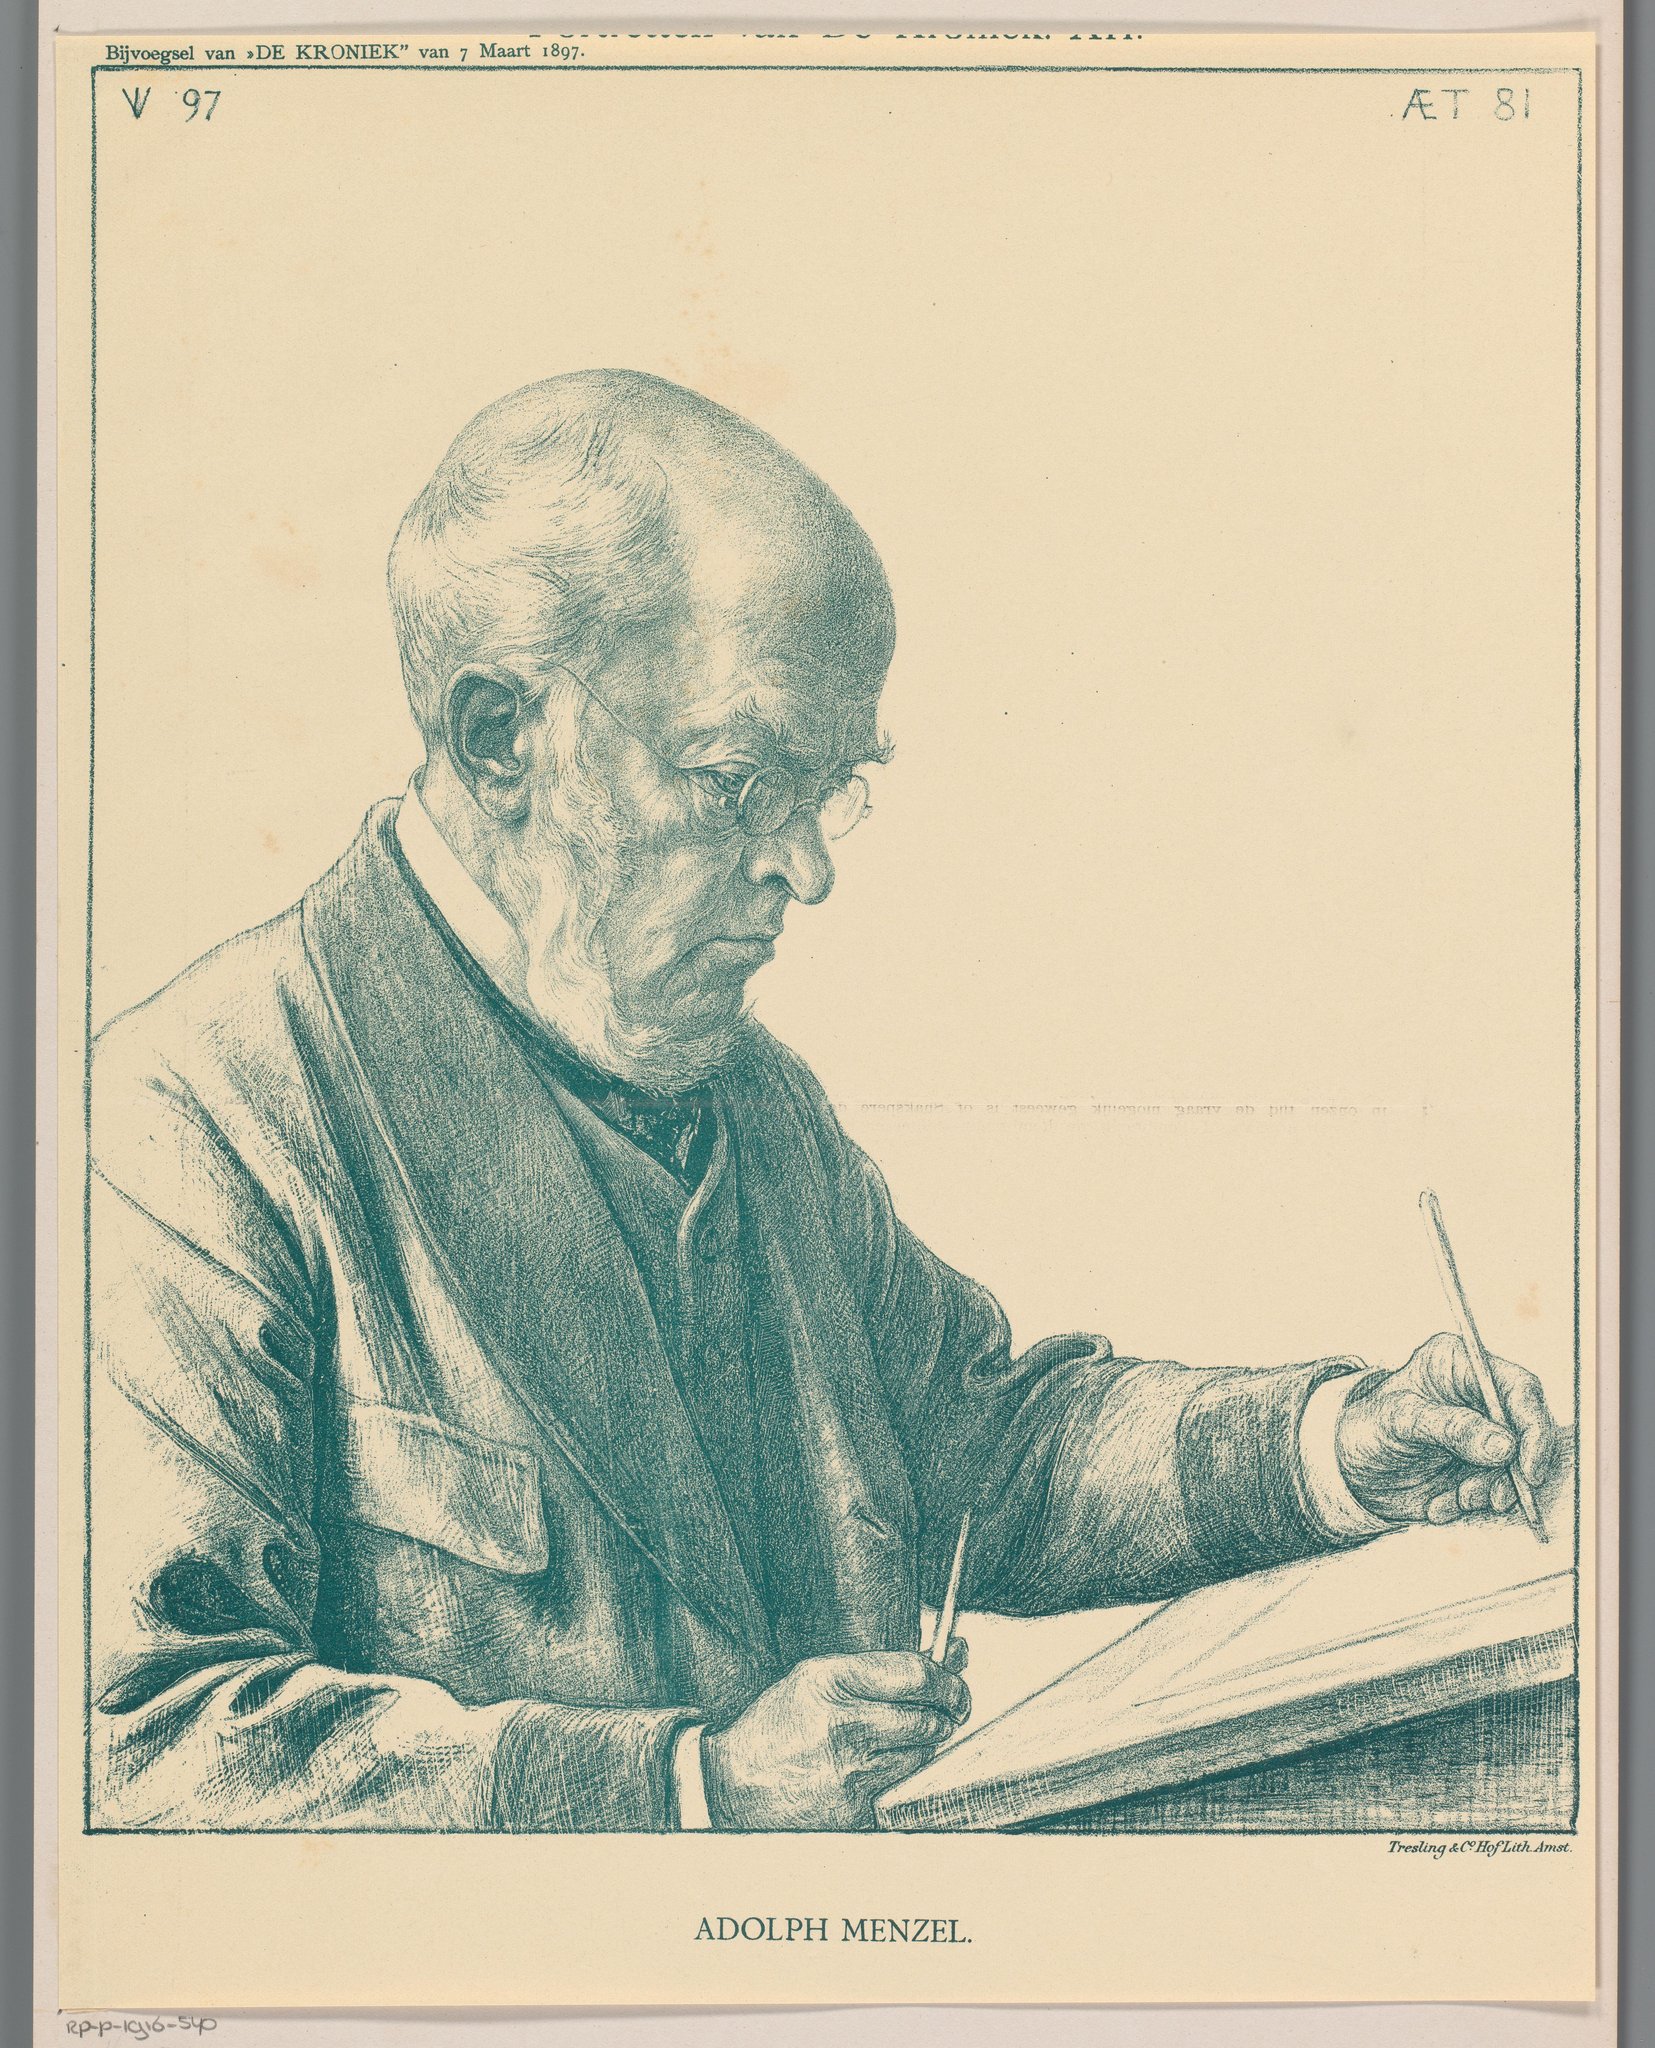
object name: print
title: Portret van Adolph Menzel op 81-jarige leeftijd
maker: jan veth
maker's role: designer, draughtsman, painter, print maker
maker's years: 1864-1925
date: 1897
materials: paper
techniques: lithograph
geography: amsterdam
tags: berlin, painter, print maker, draughtsman, adolph menzel, historical persons, draughtsman at work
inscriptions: collector's mark: Lugt 2228